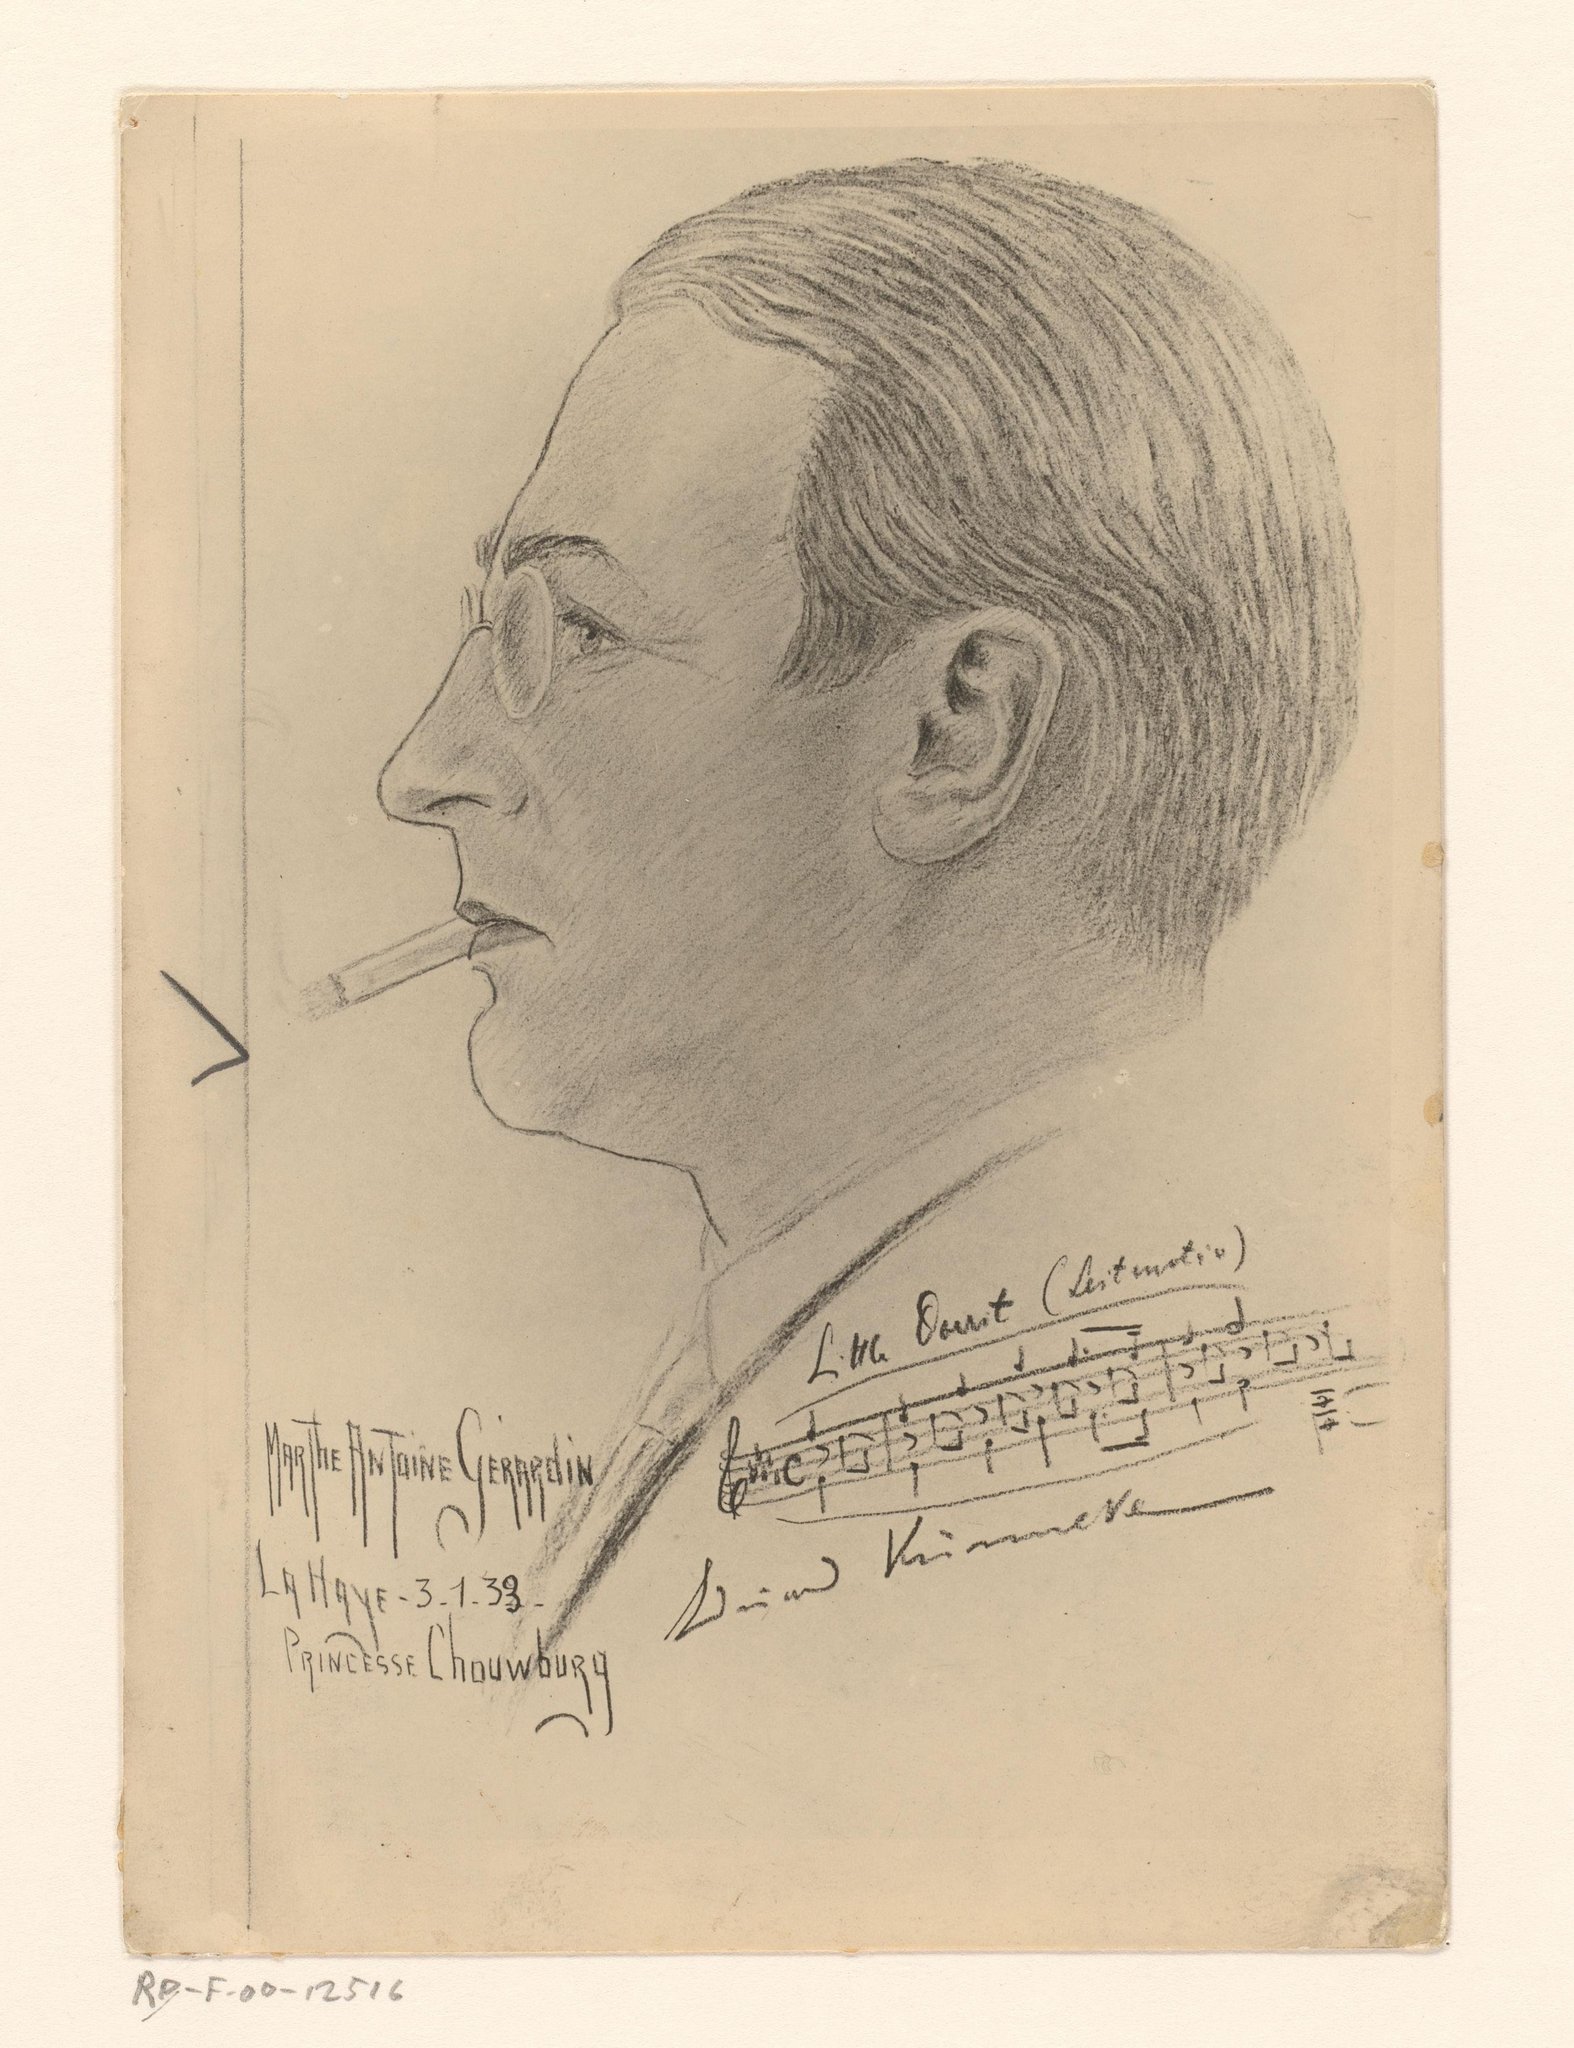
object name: reproduction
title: Fotoreproductie van een getekend portret van Eduard Künneke, door Marthe Antoine Gérardin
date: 1933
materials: paper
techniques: gelatin silver print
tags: historical persons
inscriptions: inscription: ‘La Haye-3-1-33/ Princesse Chouwburg’